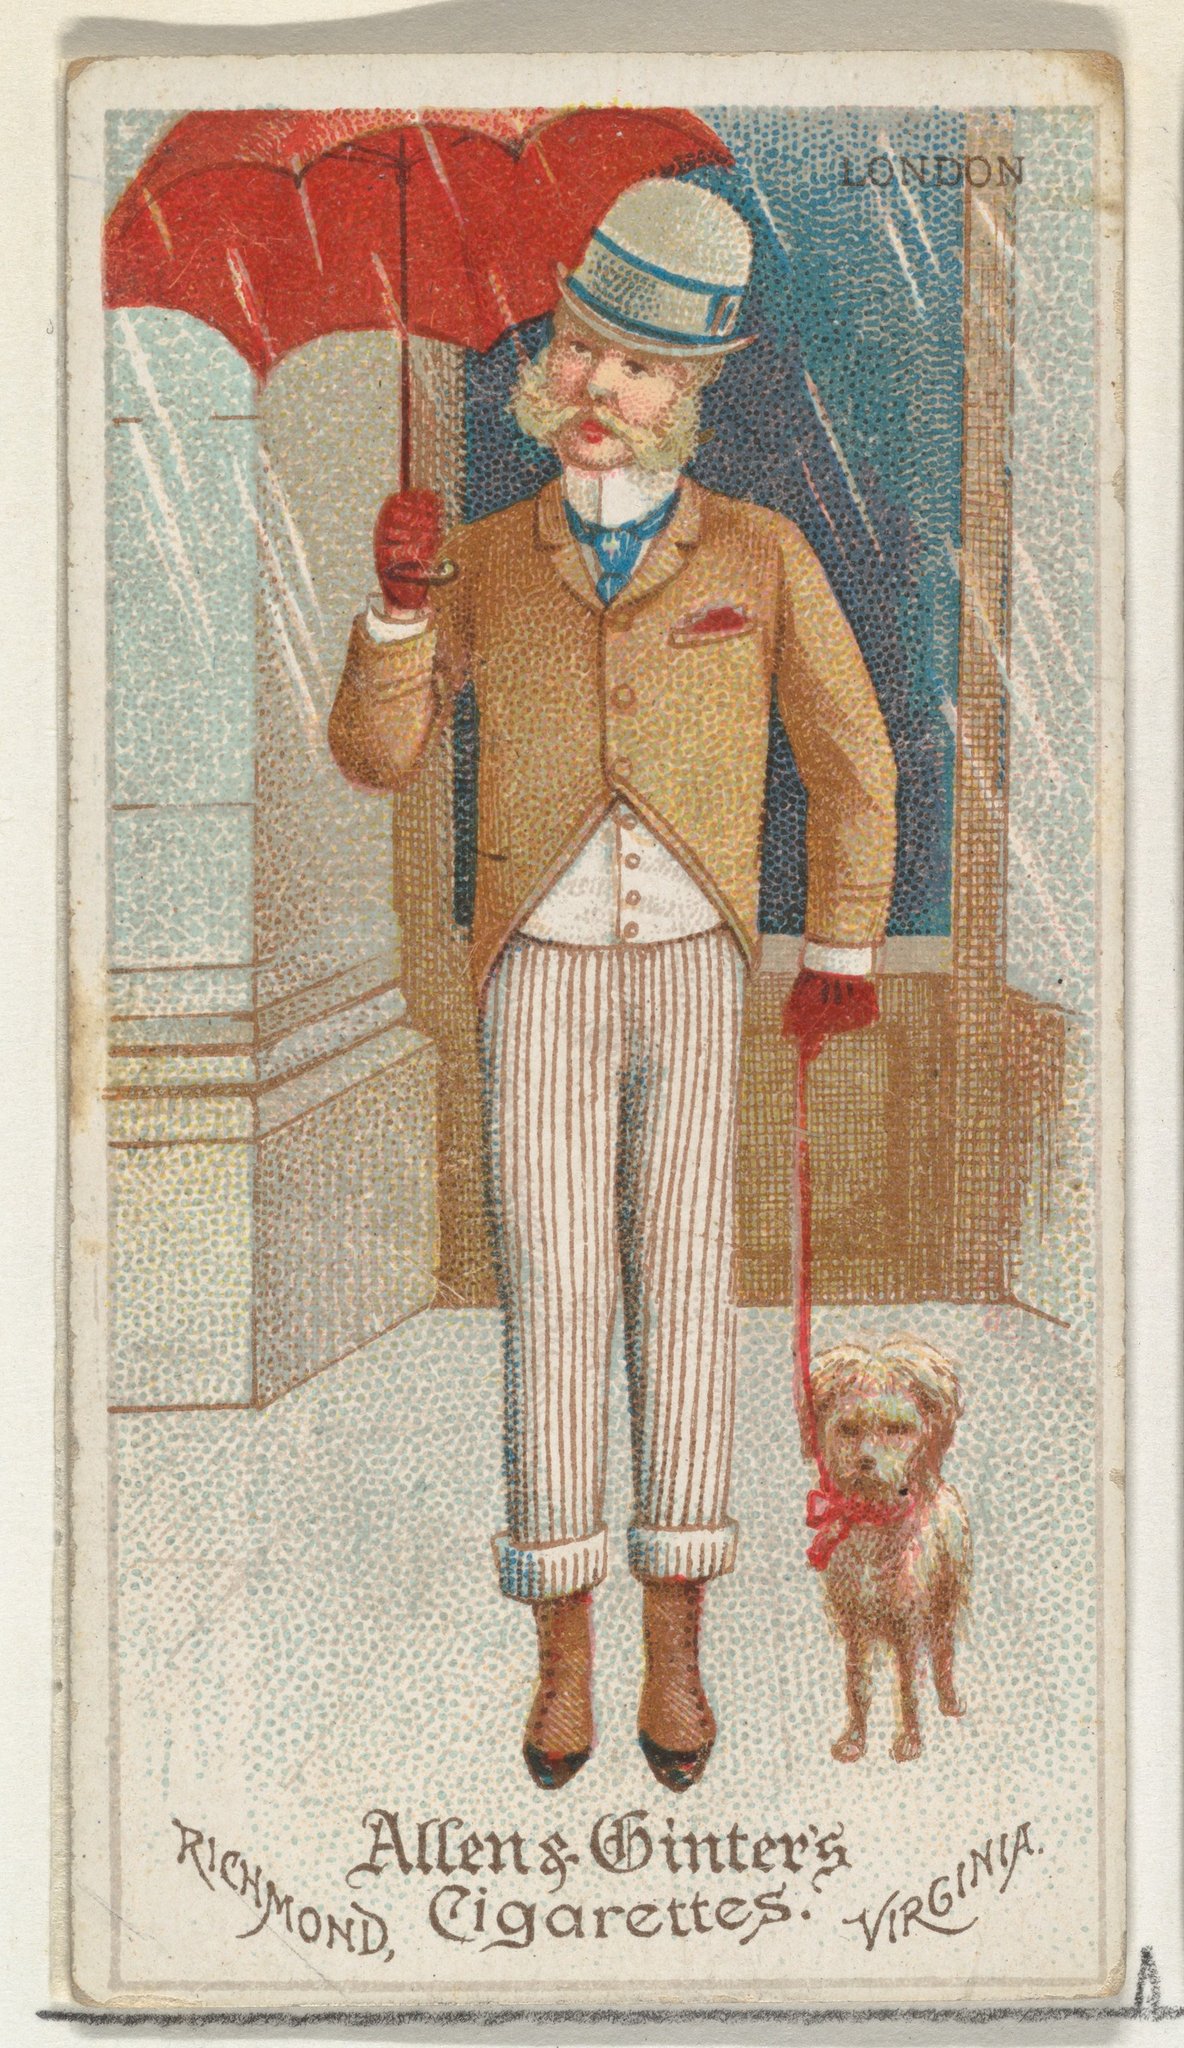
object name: print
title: London, from World's Dudes series (N31) for Allen & Ginter Cigarettes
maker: allen & ginter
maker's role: publisher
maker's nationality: american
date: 1888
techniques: color lithograph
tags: men,dogs